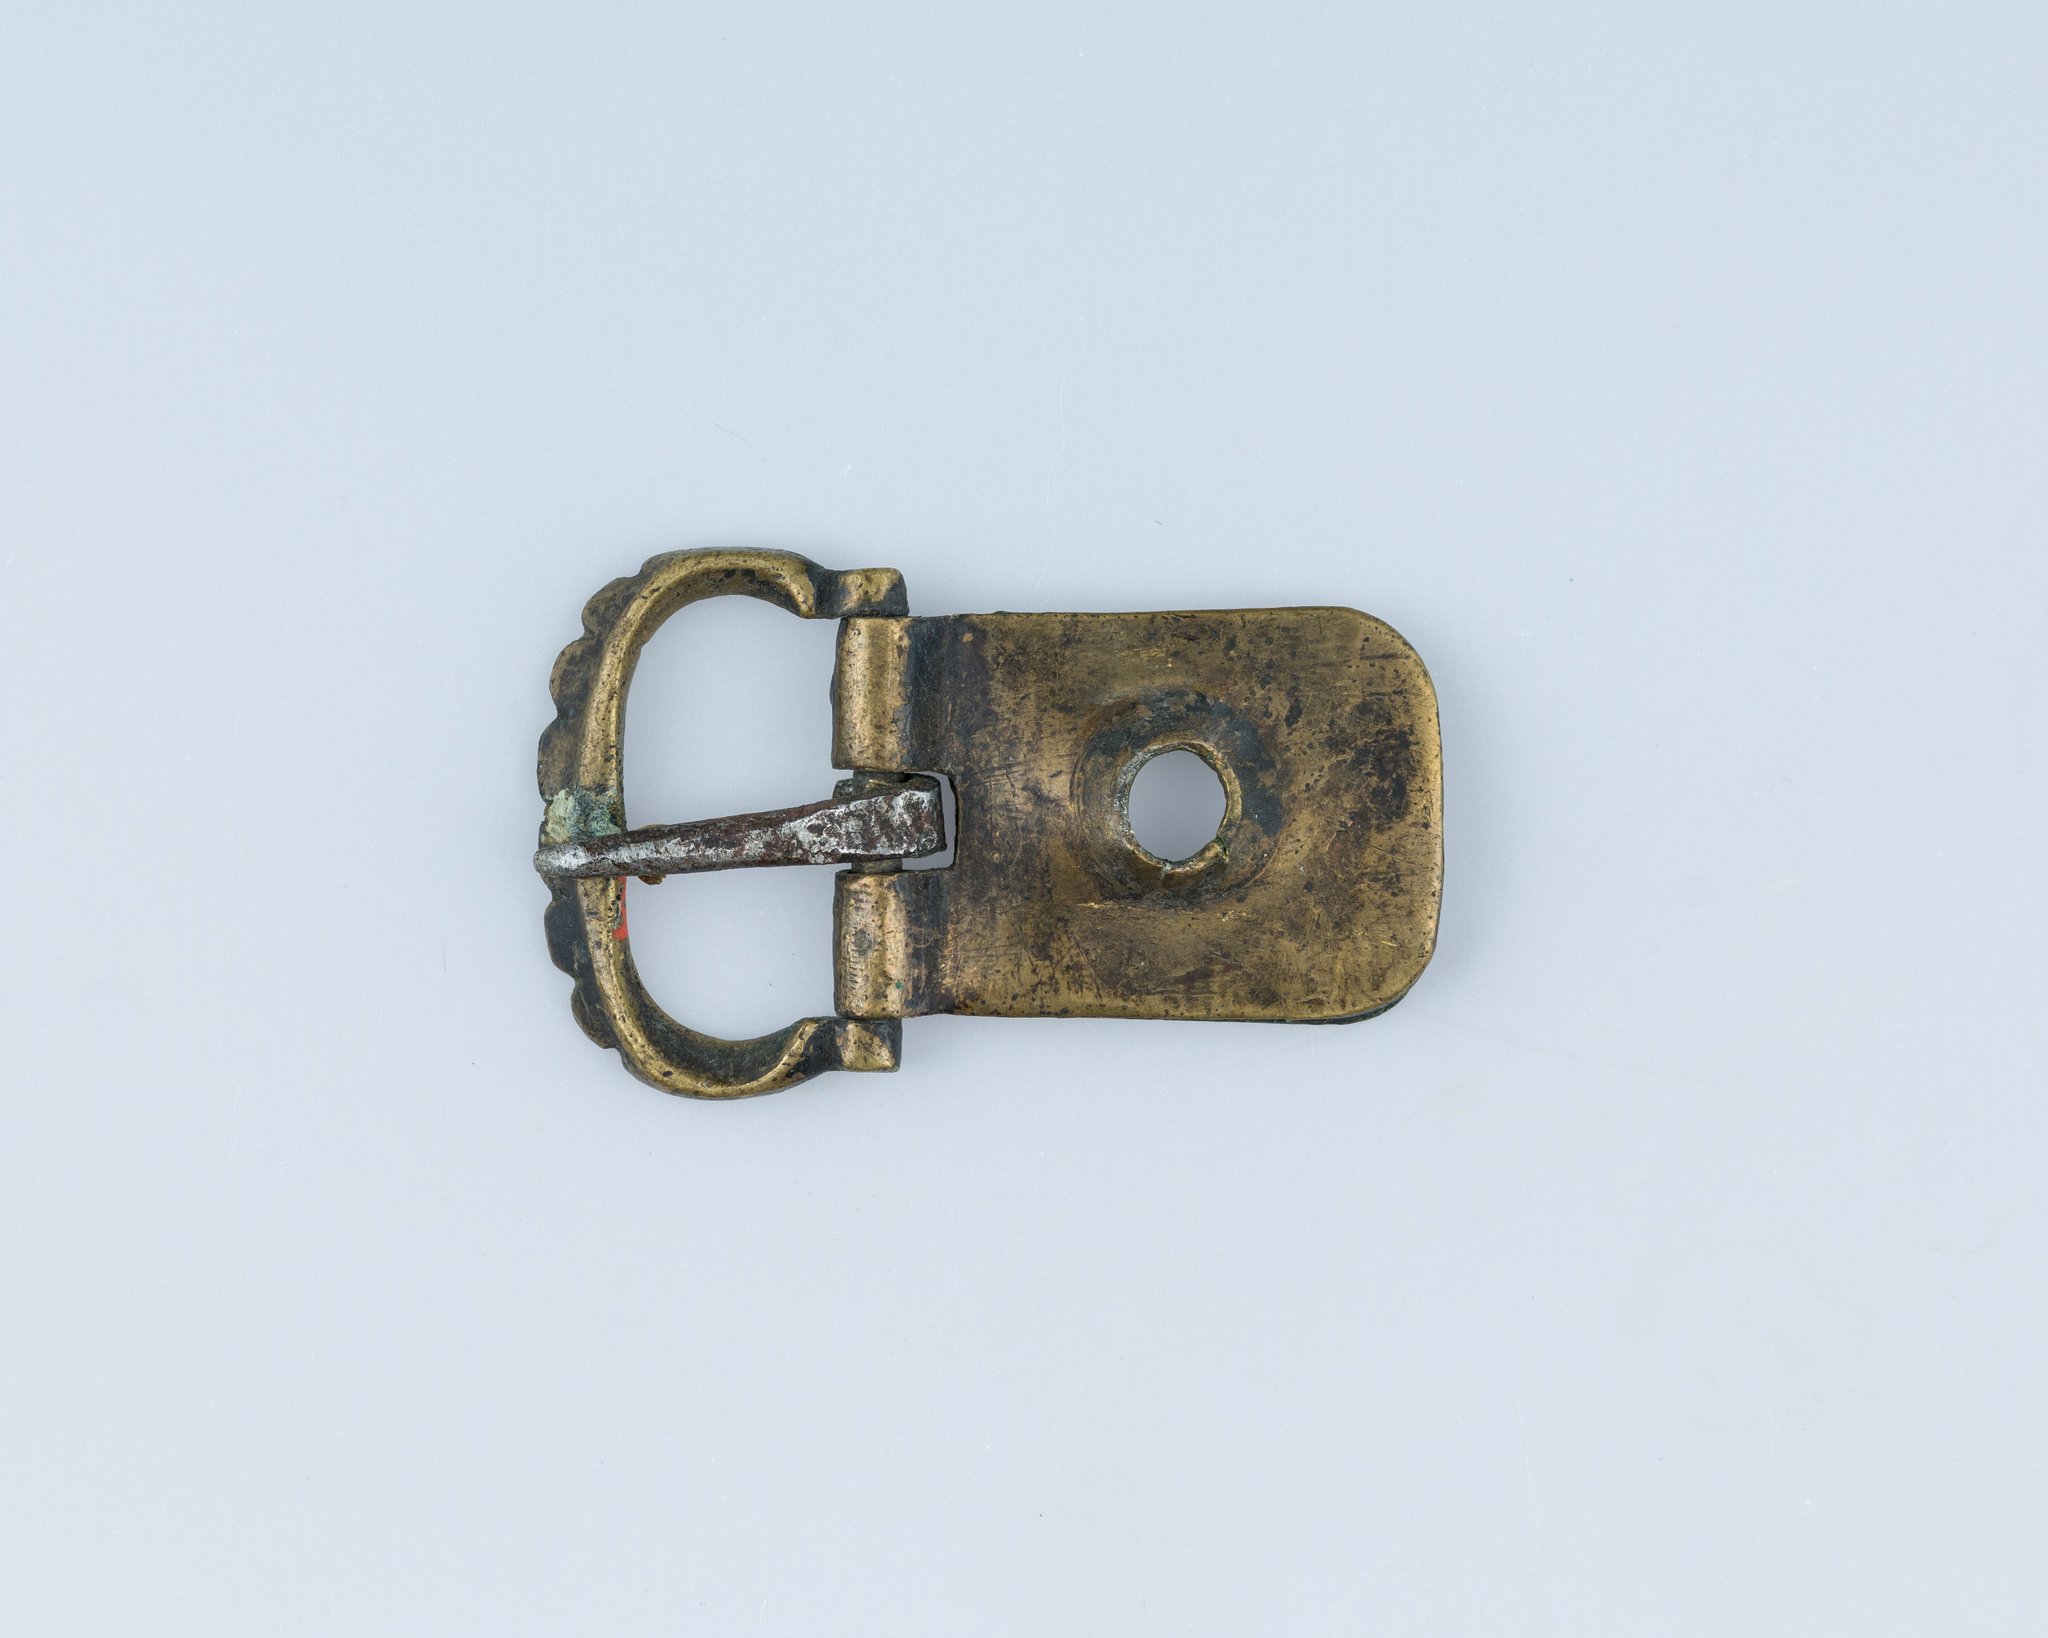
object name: buckle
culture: german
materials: brass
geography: germany